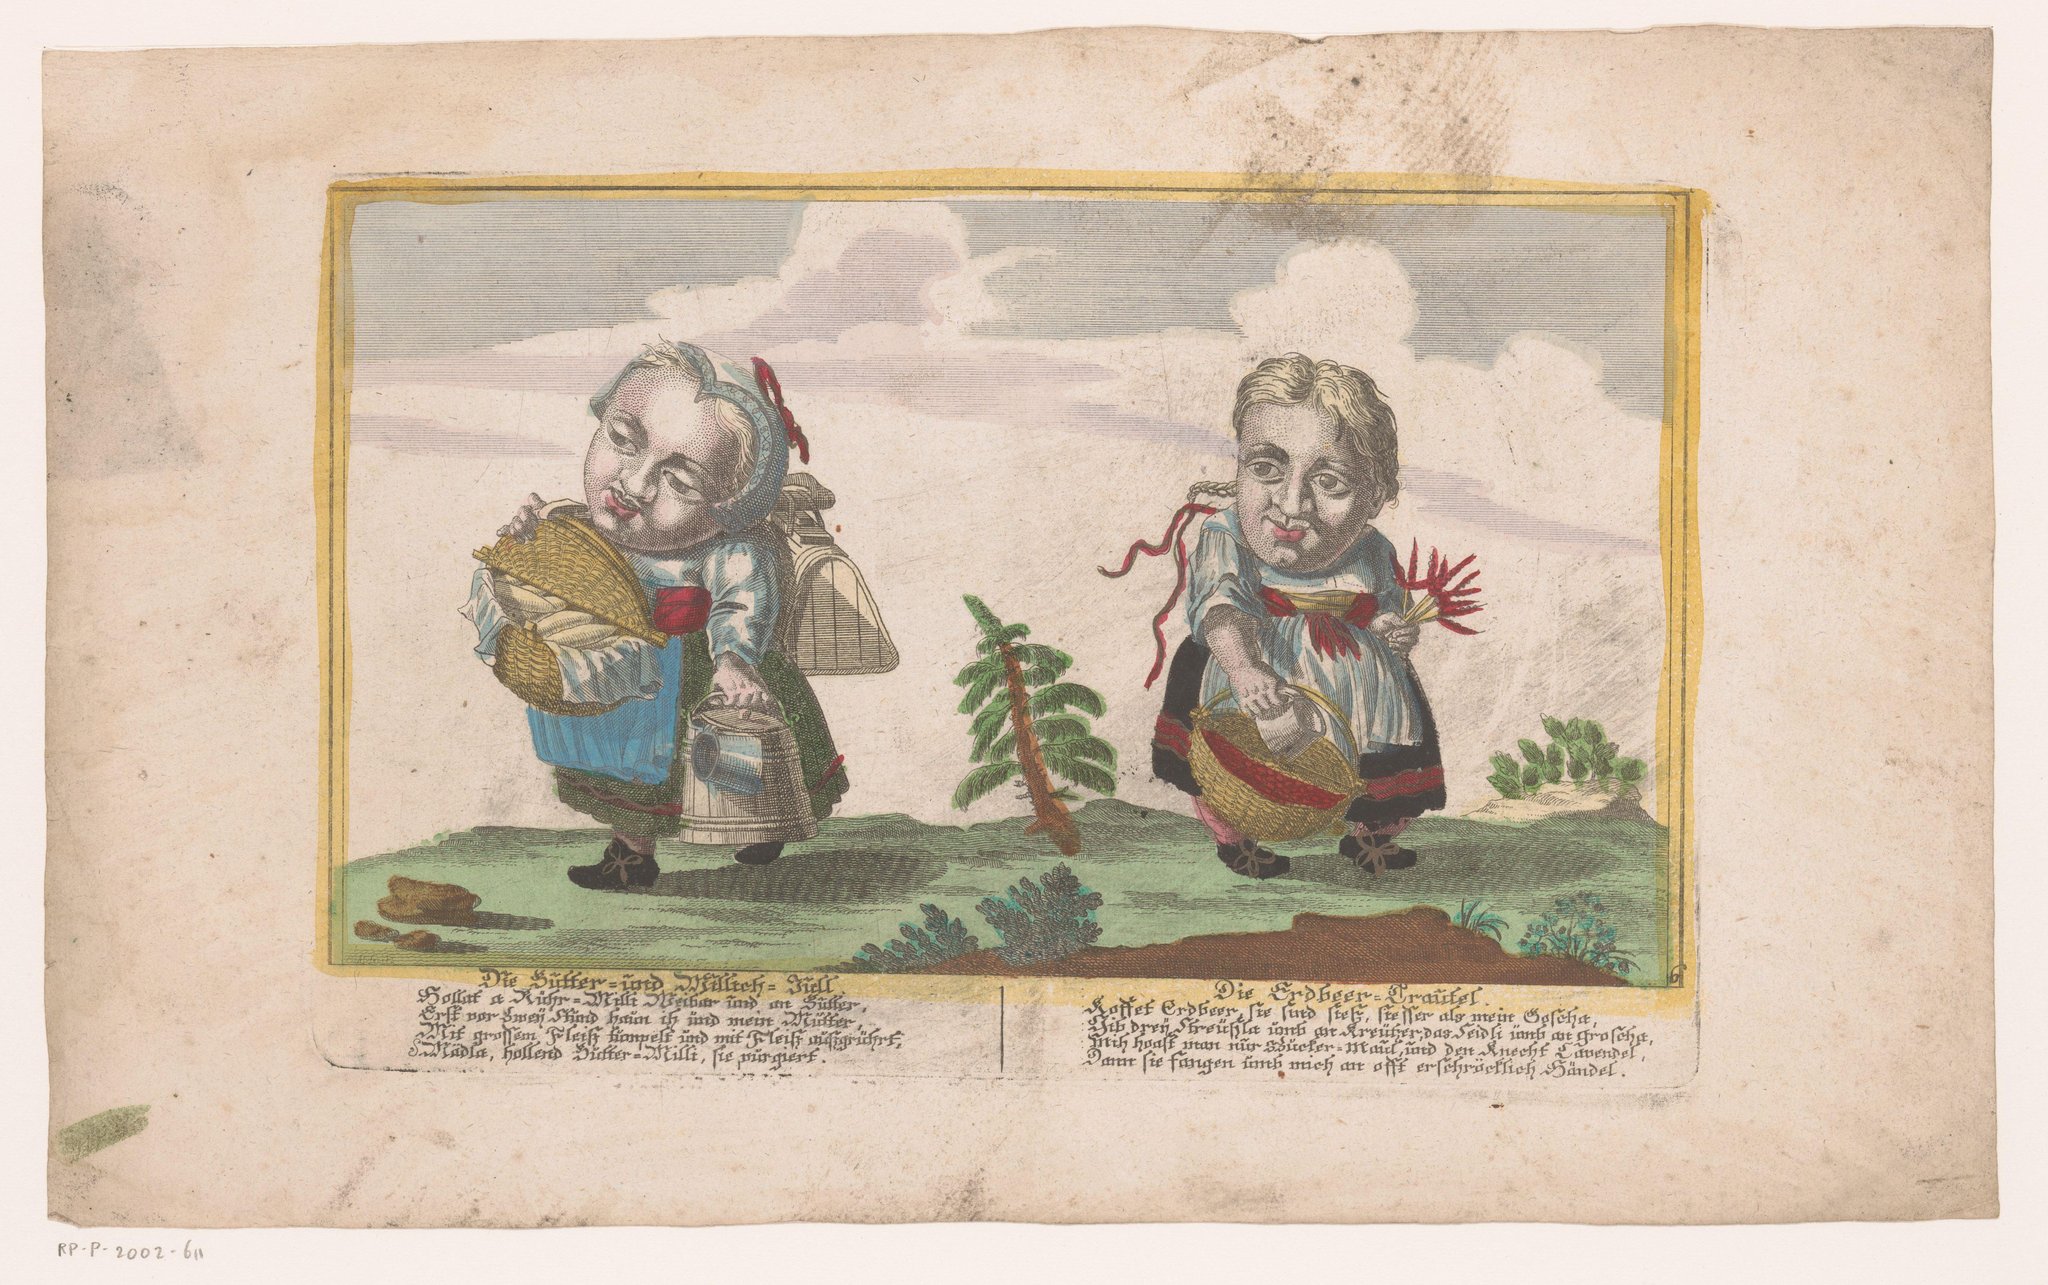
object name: cartoon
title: Twee dwergen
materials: paper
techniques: engraving, hand coloring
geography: germany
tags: little people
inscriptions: collector's mark: Lugt 2228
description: Twee vrouwen (kleine mensen): de rechter draagt een mand met bessen, de linker draagt een mand met ander voedsel.